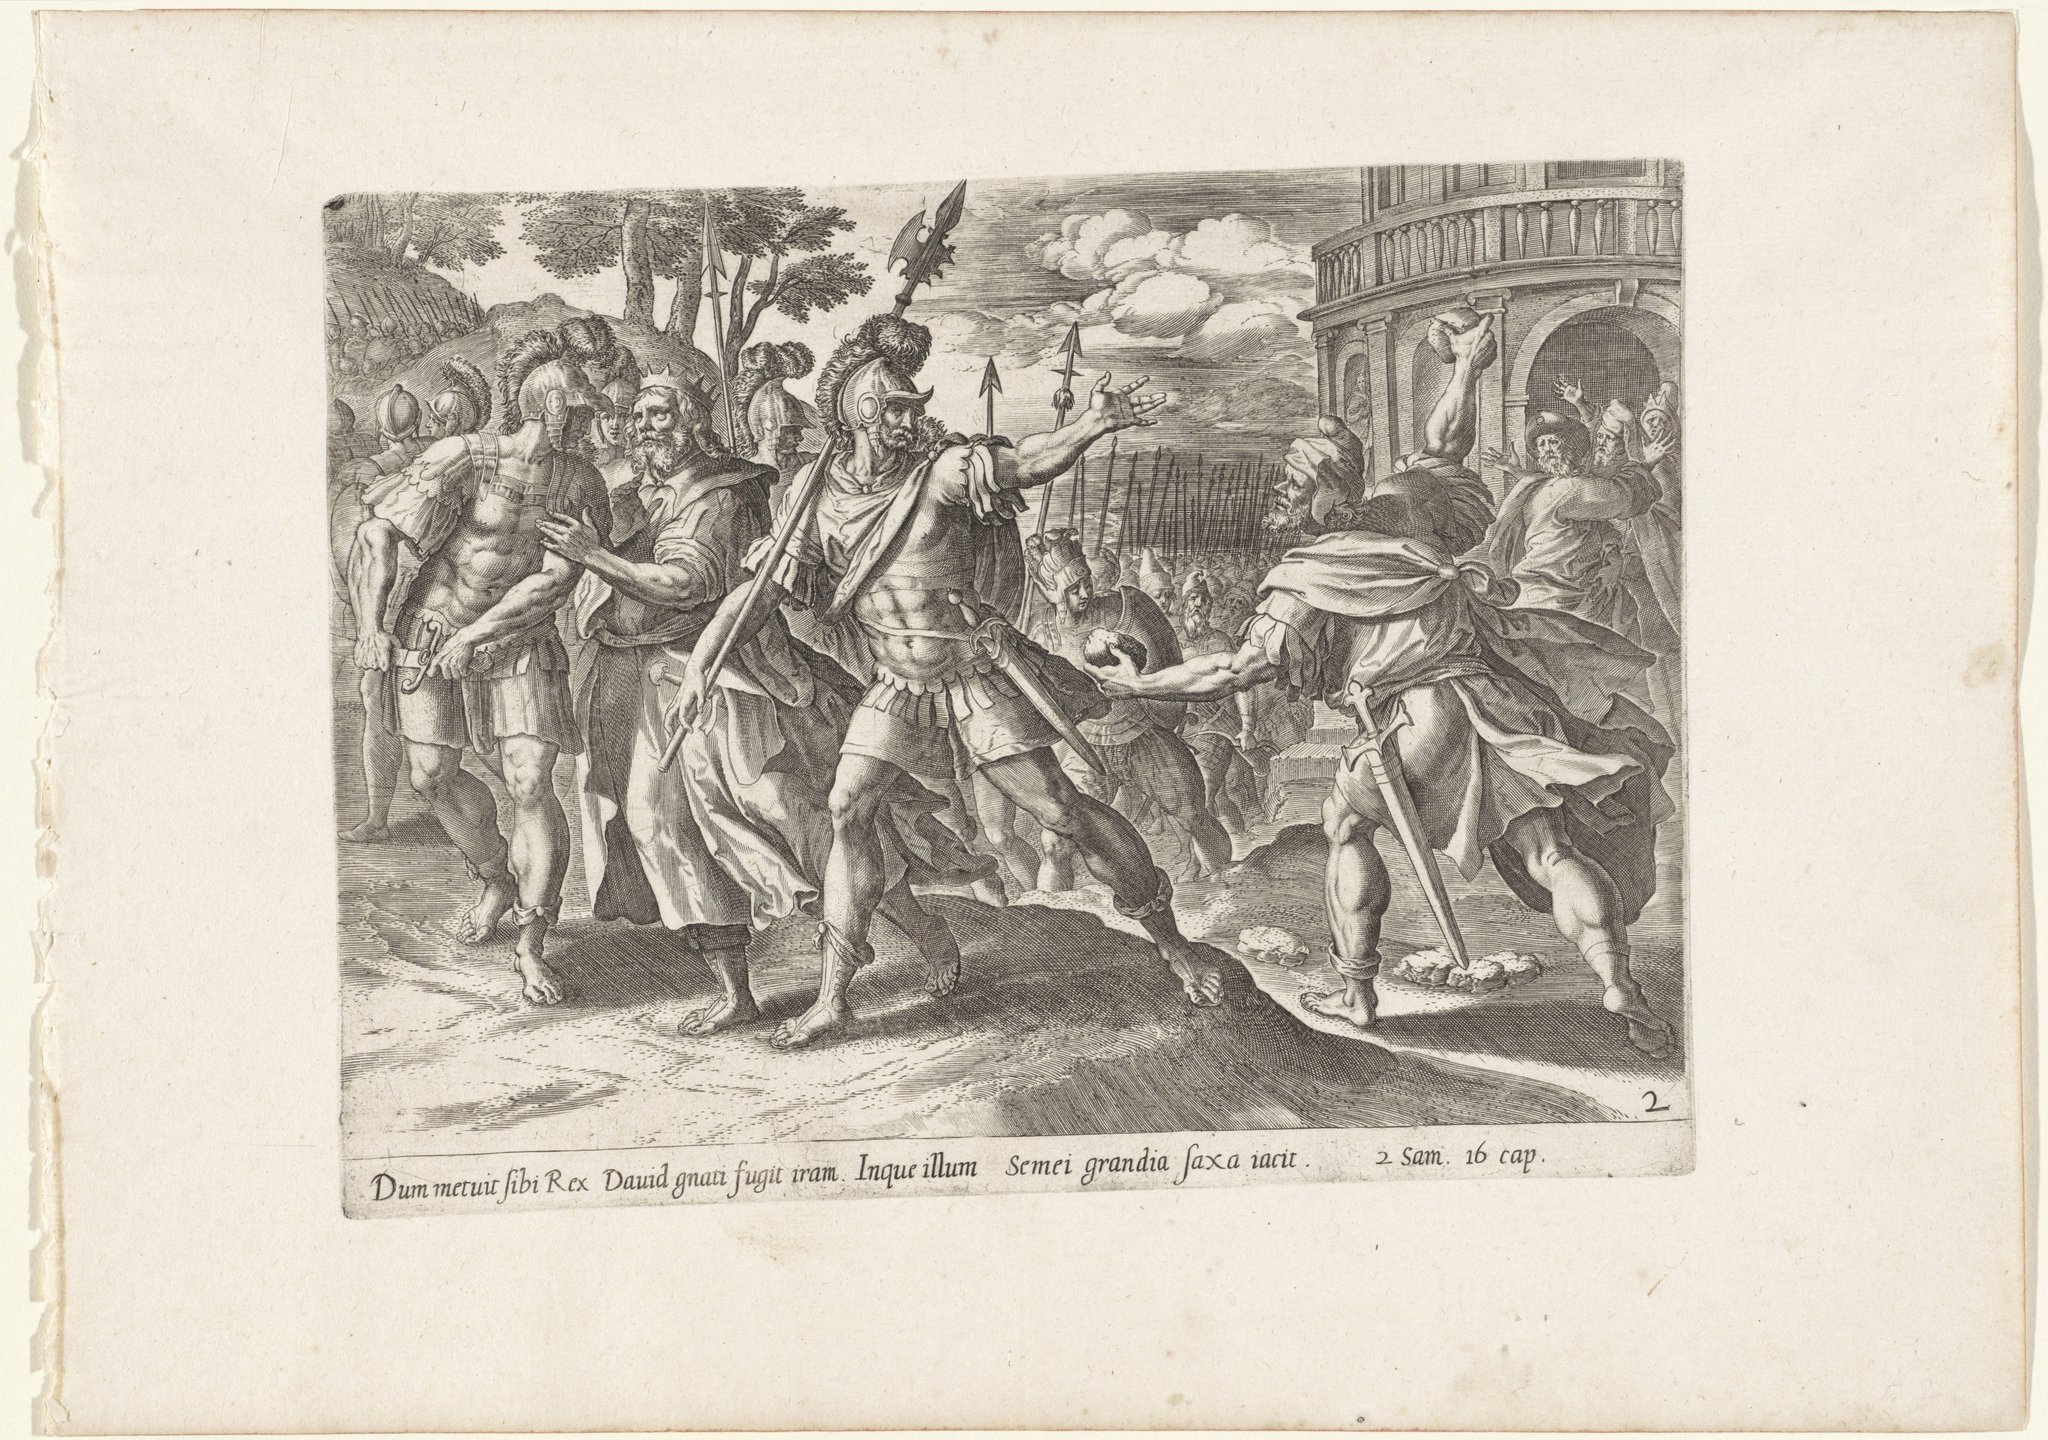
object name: print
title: Simi vervloekt koning David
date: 1585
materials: paper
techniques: engraving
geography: antwerp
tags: shimei curses david and casts stones at him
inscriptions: collector's mark: Lugt 2228, collector's mark: Lugt 2760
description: Prent gebruikt in: Thesaurus sacrarum historiaru[m] veteris (et novi) testame[n]ti, elega[n]tissimis imaginibus expressu[m] excelle[n]tissimoru[m] in hac arte viroru[m] opera : nu[n]c primu[m] in luce[m] editus. Antwerpen: Gerard de Jode, 1585.